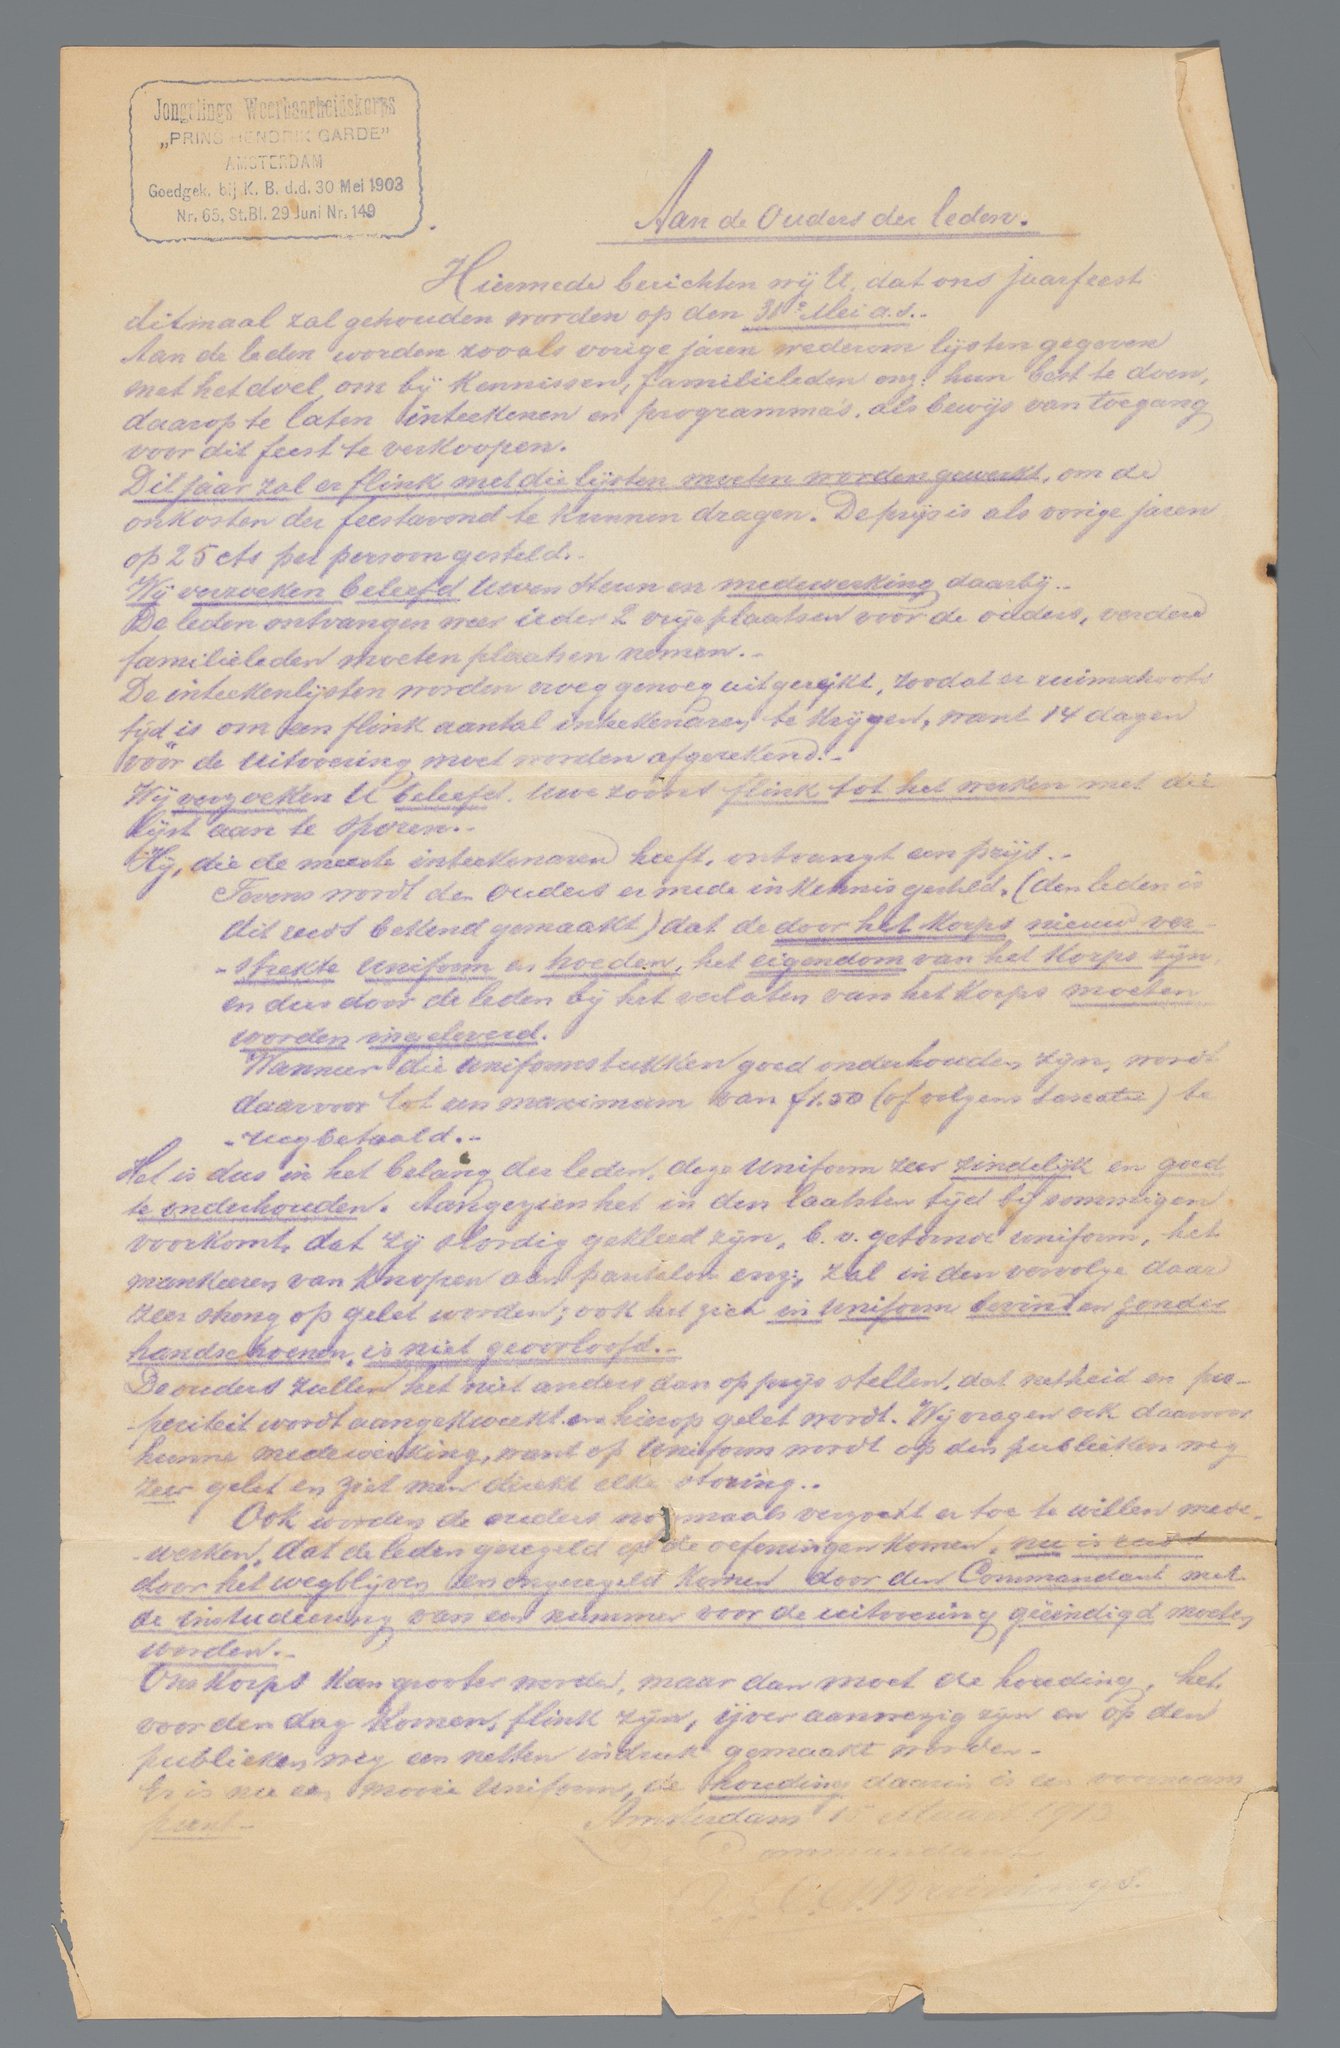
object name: document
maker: commandant prins hendrik garde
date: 1910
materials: paper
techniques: printing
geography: amsterdam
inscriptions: date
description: Document met betrekking tot de Amsterdamse "Prins Hendrik Garde" voor jongens; Brief, eenzijdig beschreven blad over jaarfeest PHG. Gedateerd en gesigneerd.